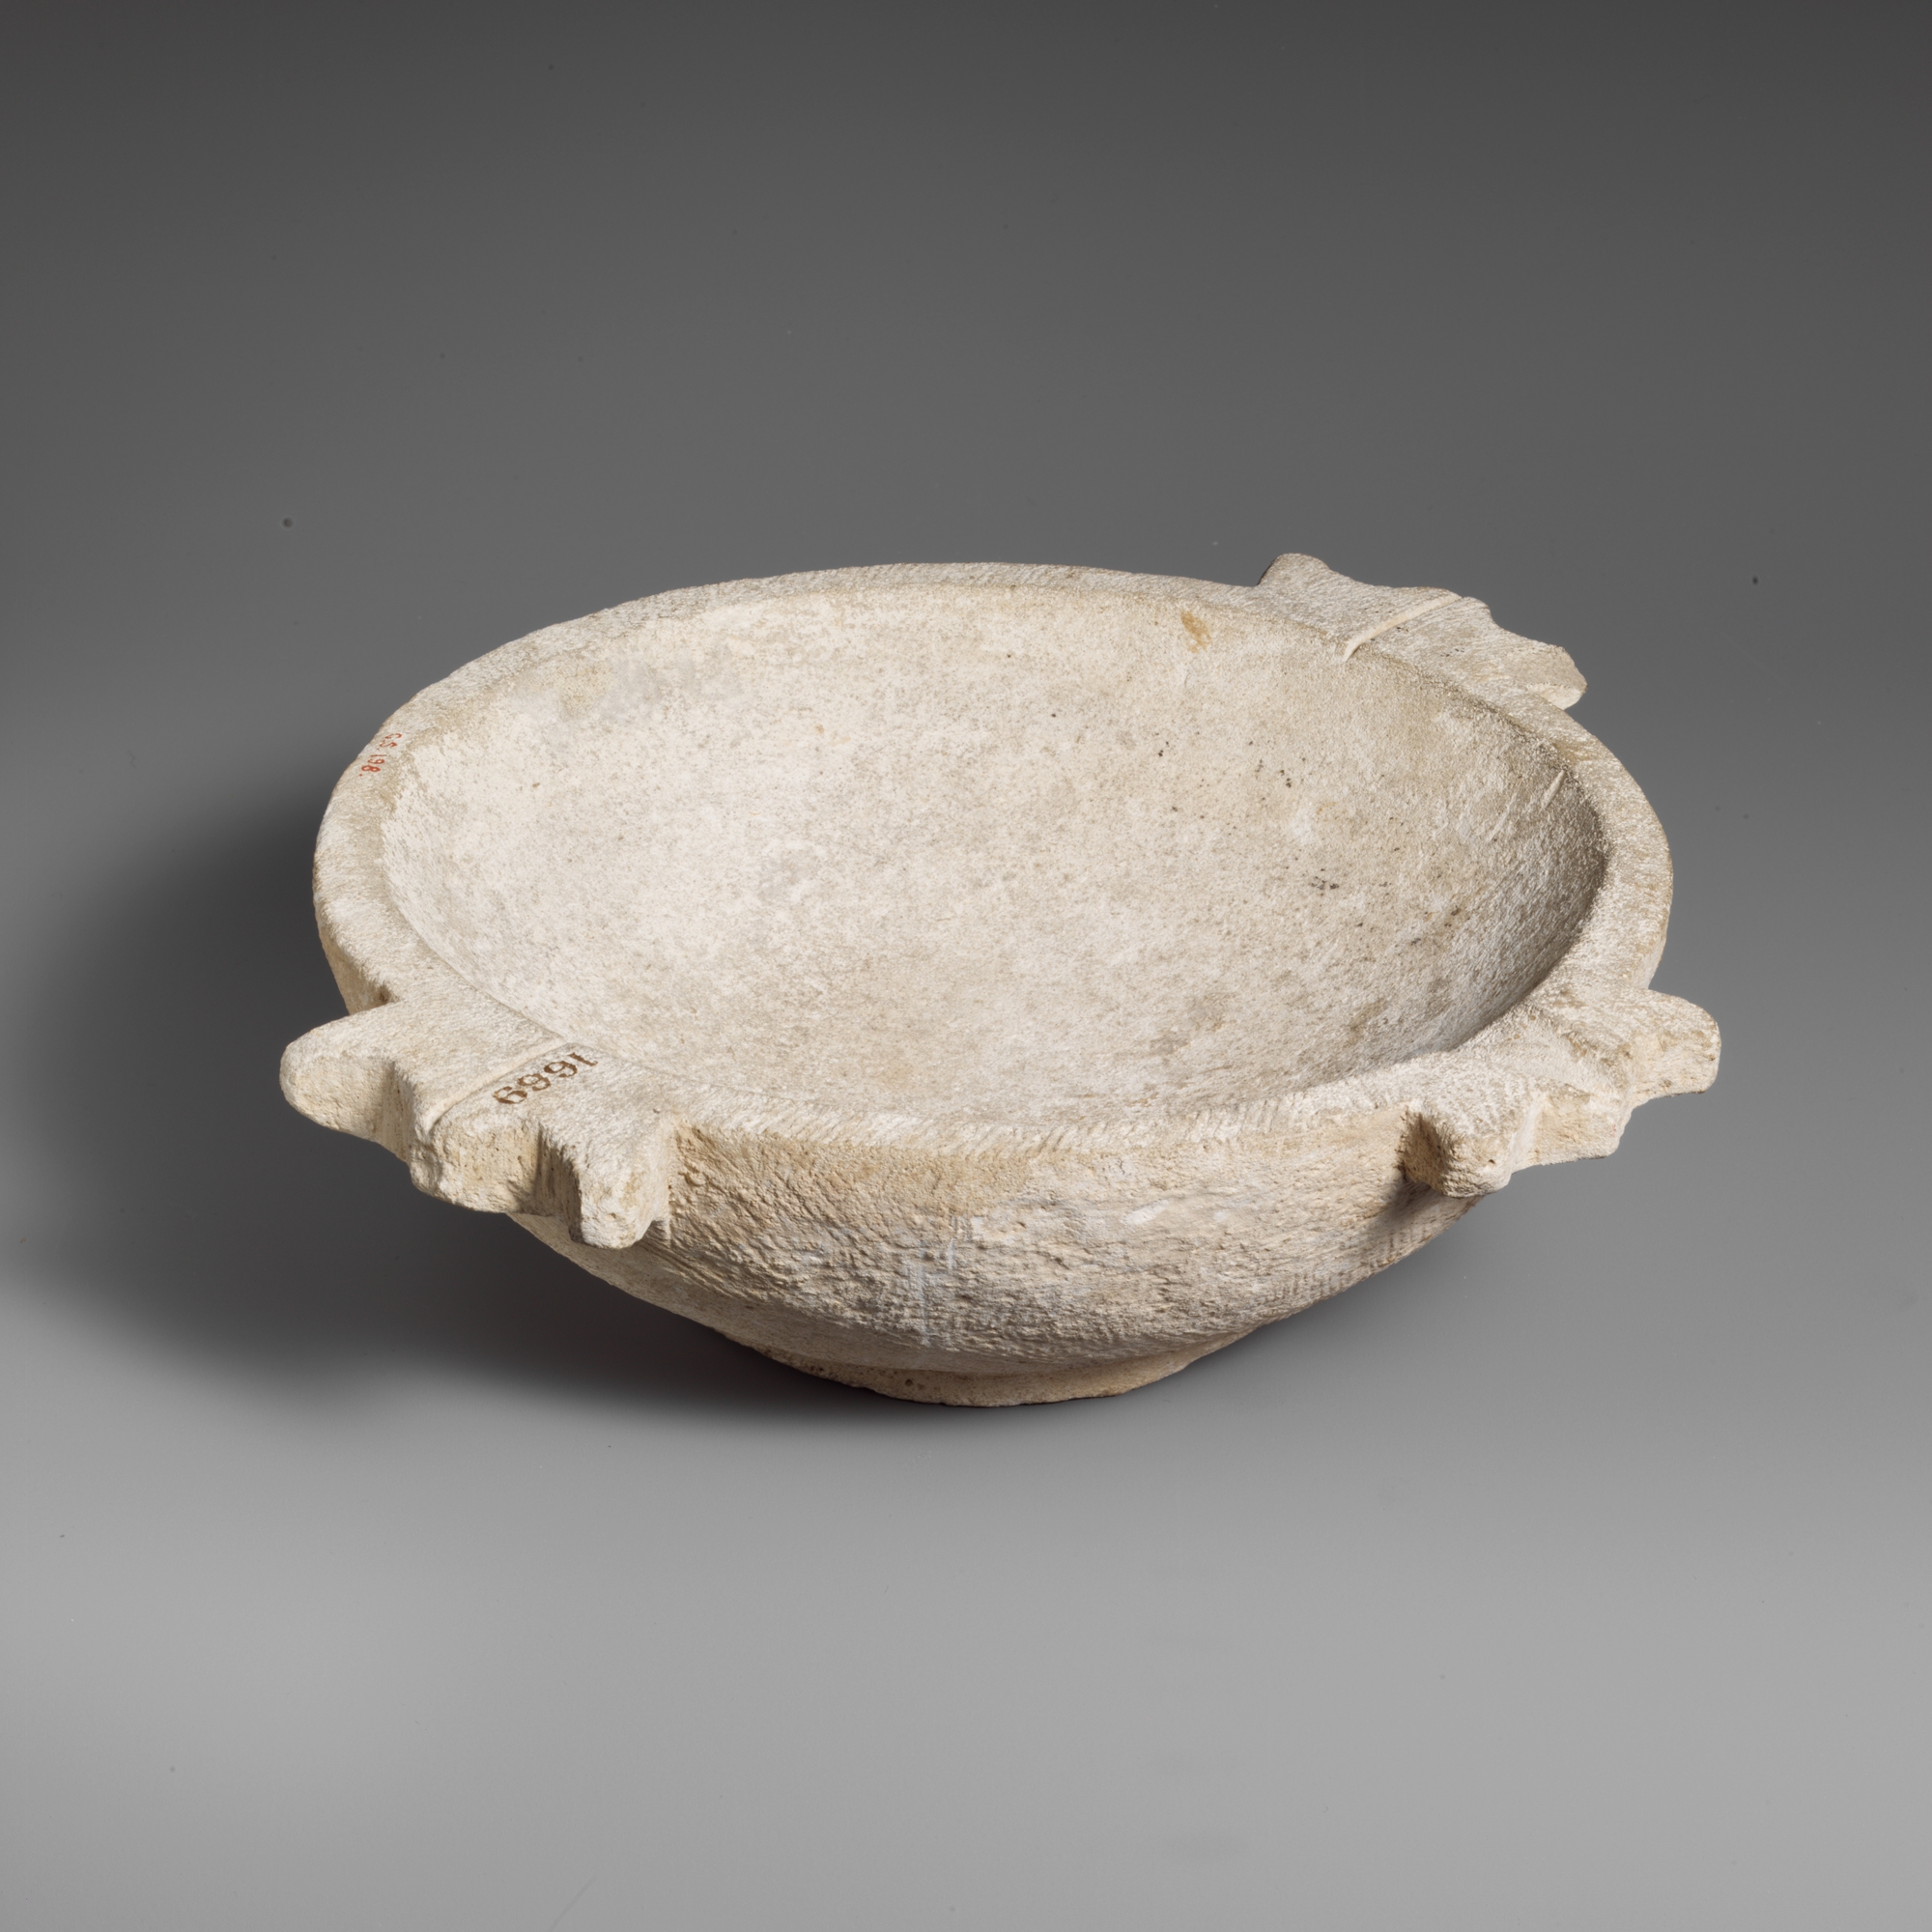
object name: bowl with spout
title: Limestone mortar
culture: cypriot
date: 3900 BCE-100 CE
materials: limestone